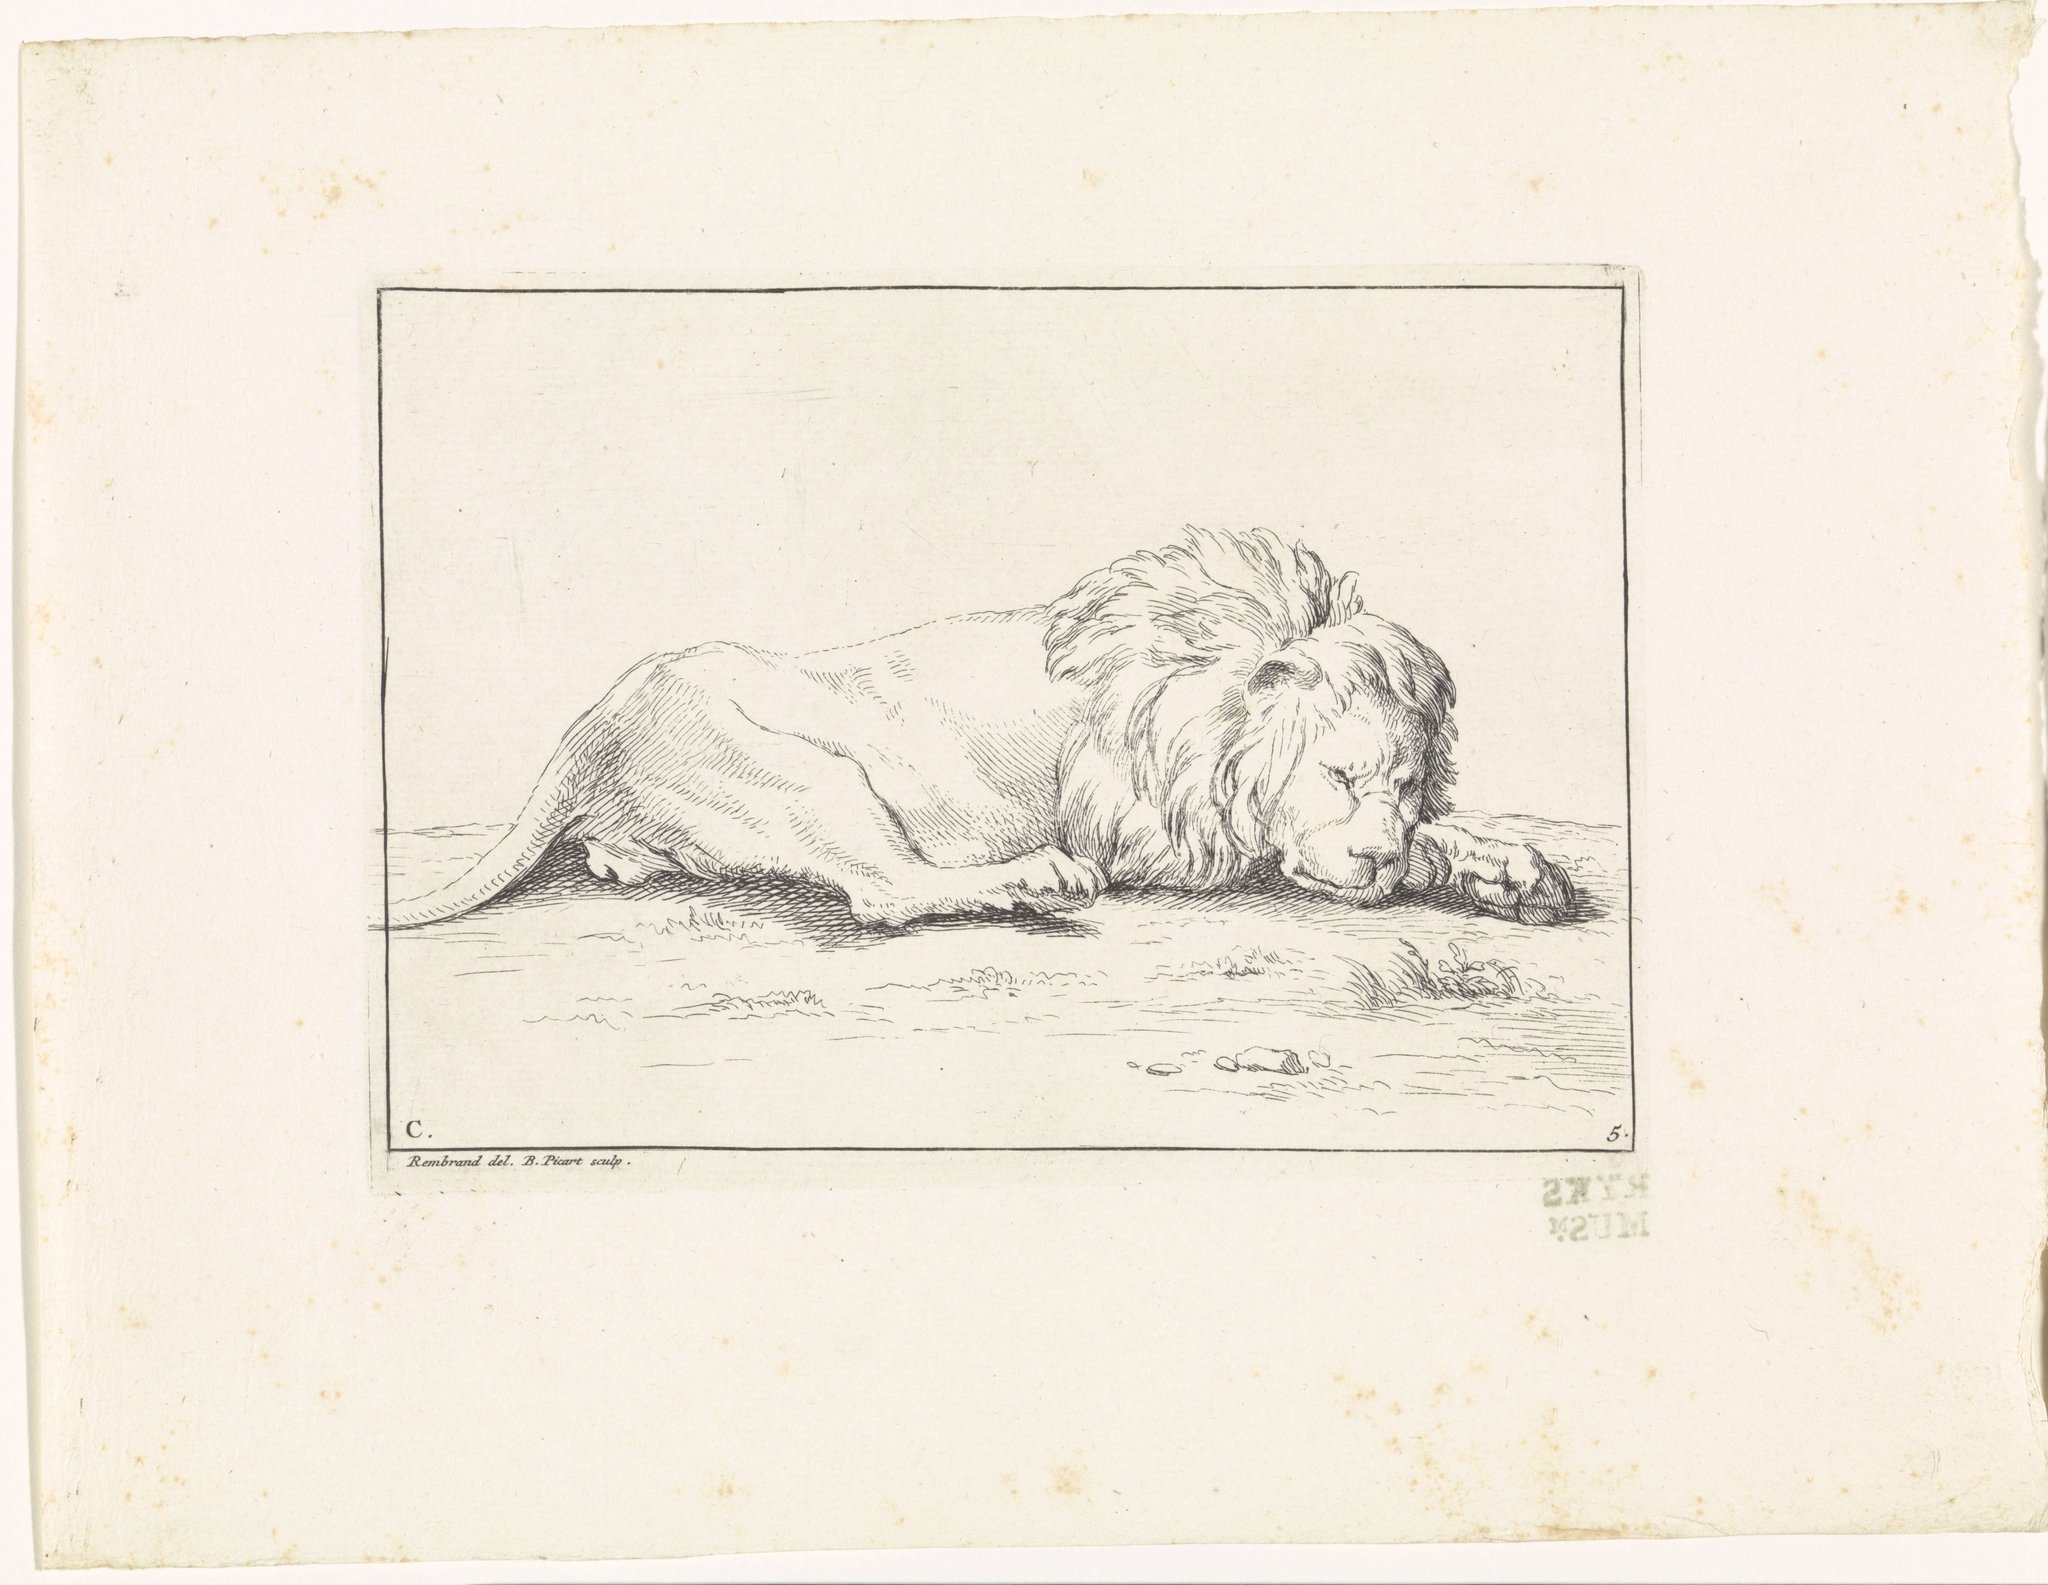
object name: book illustration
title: Slapende leeuw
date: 1729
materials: paper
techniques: etching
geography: amsterdam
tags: beasts of prey, predatory animals: lion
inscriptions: collector's mark: Lugt 2165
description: Prent ook als illustratie gebruikt in: Recueil de lions, dessinez d'après nature par divers maitres. Amsterdam: Bernard Picart, 1729.